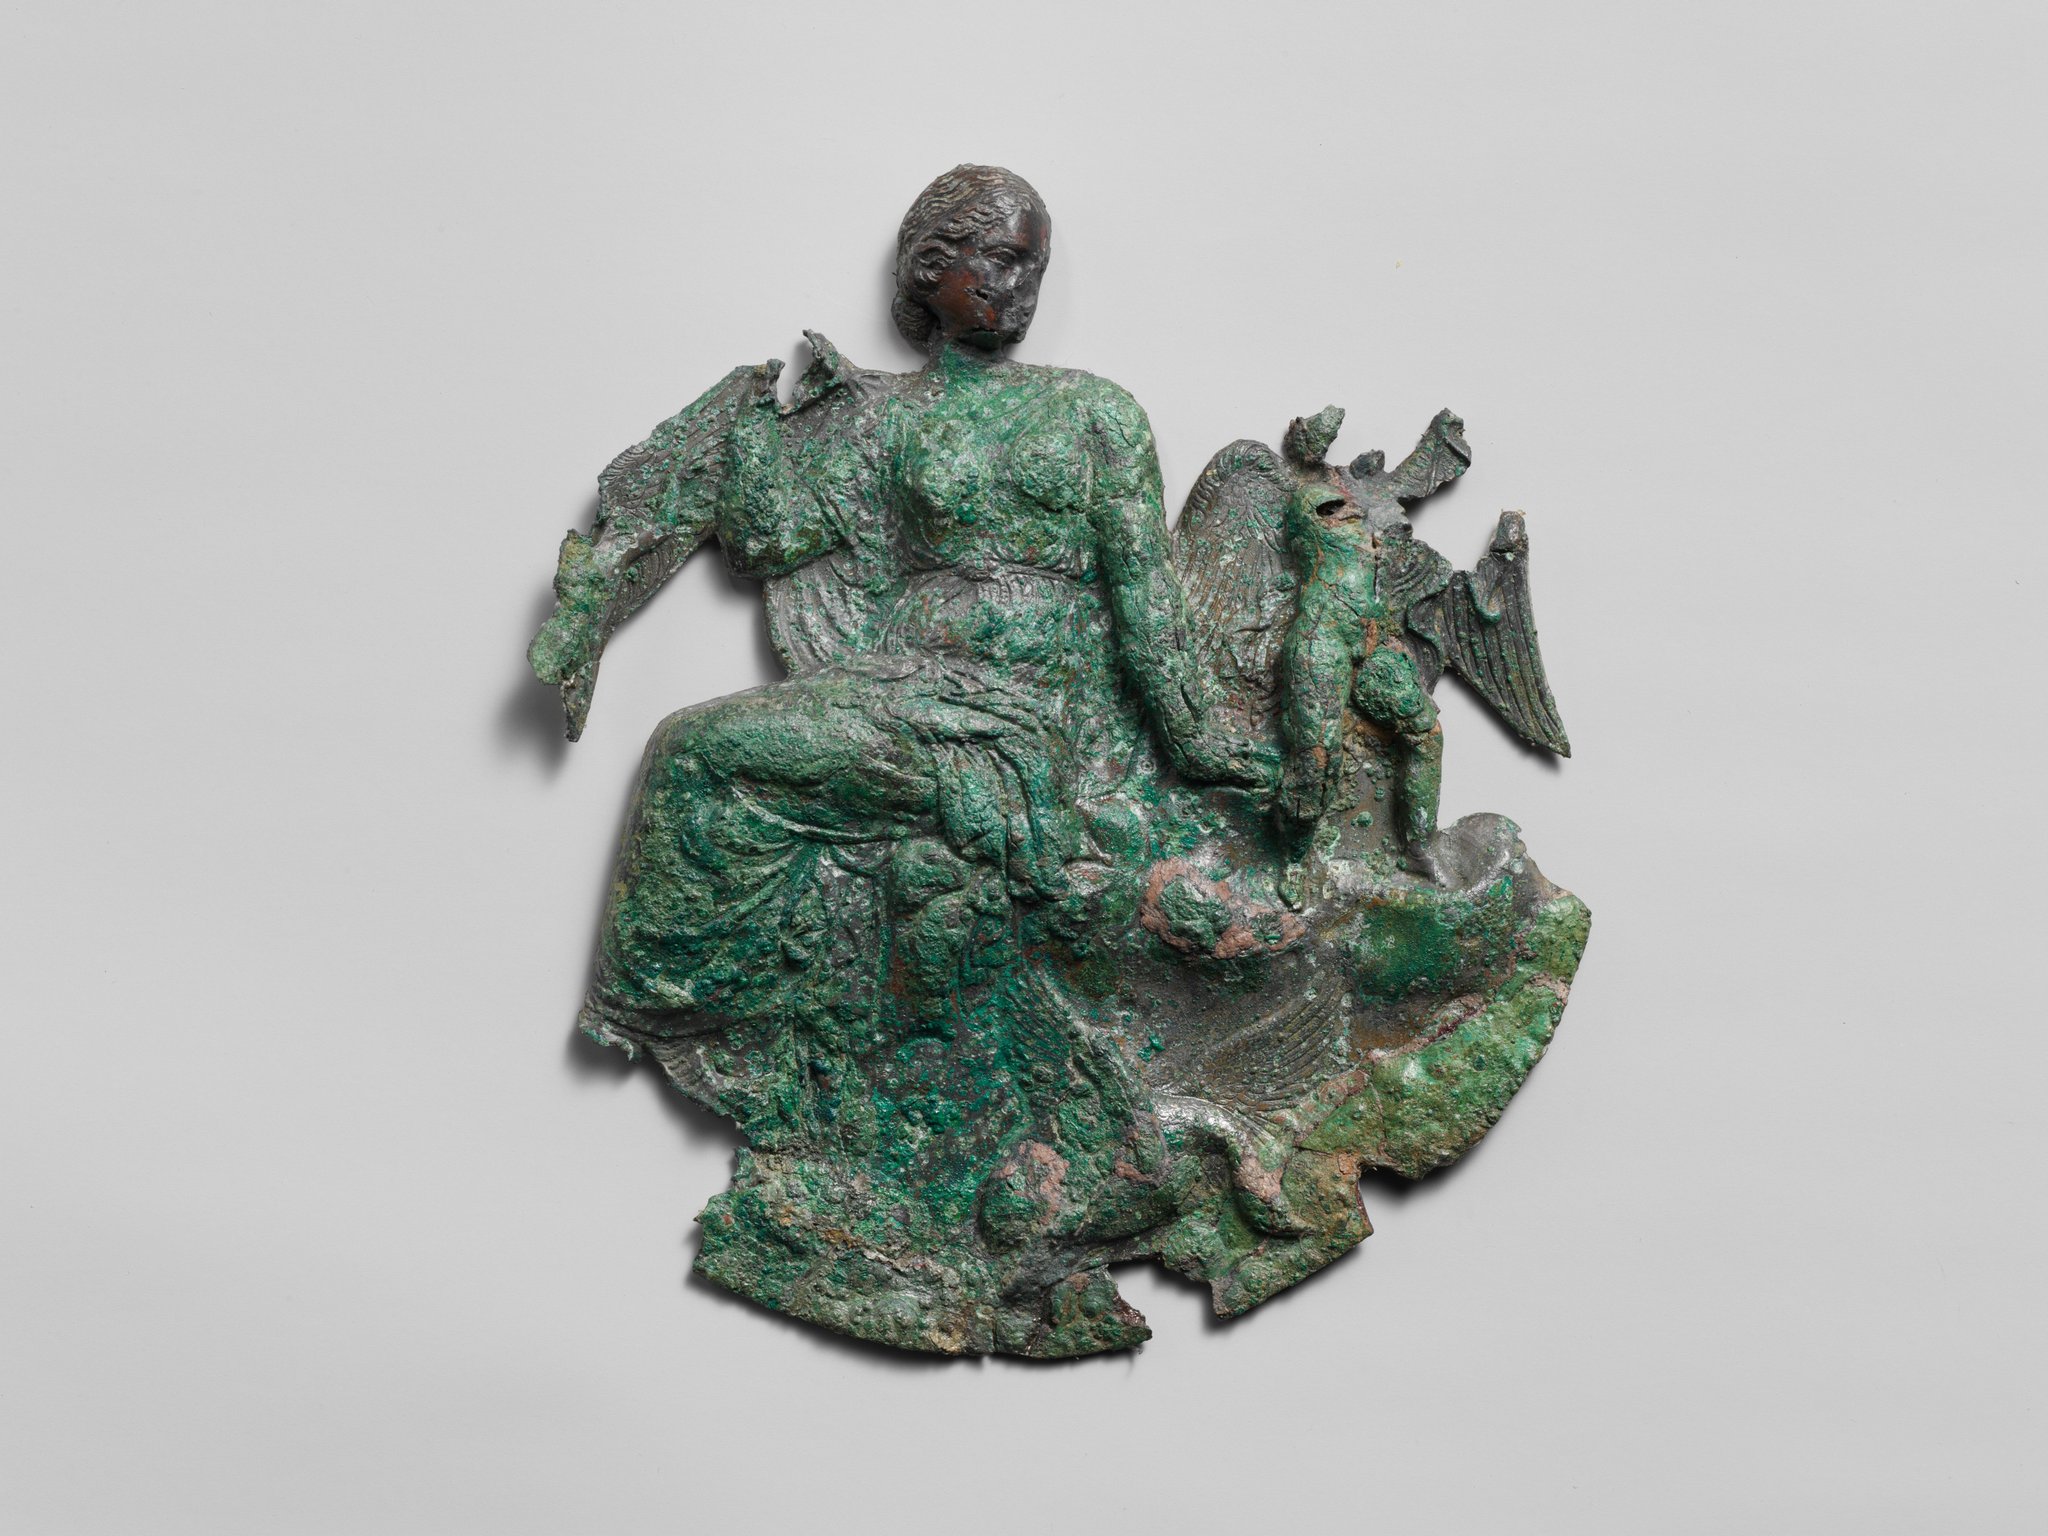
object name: mirror with aphrodite and erotes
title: Bronze relief from a mirror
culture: greek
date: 400-301 BCE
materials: bronze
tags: aphrodite,zeus,leda,swans